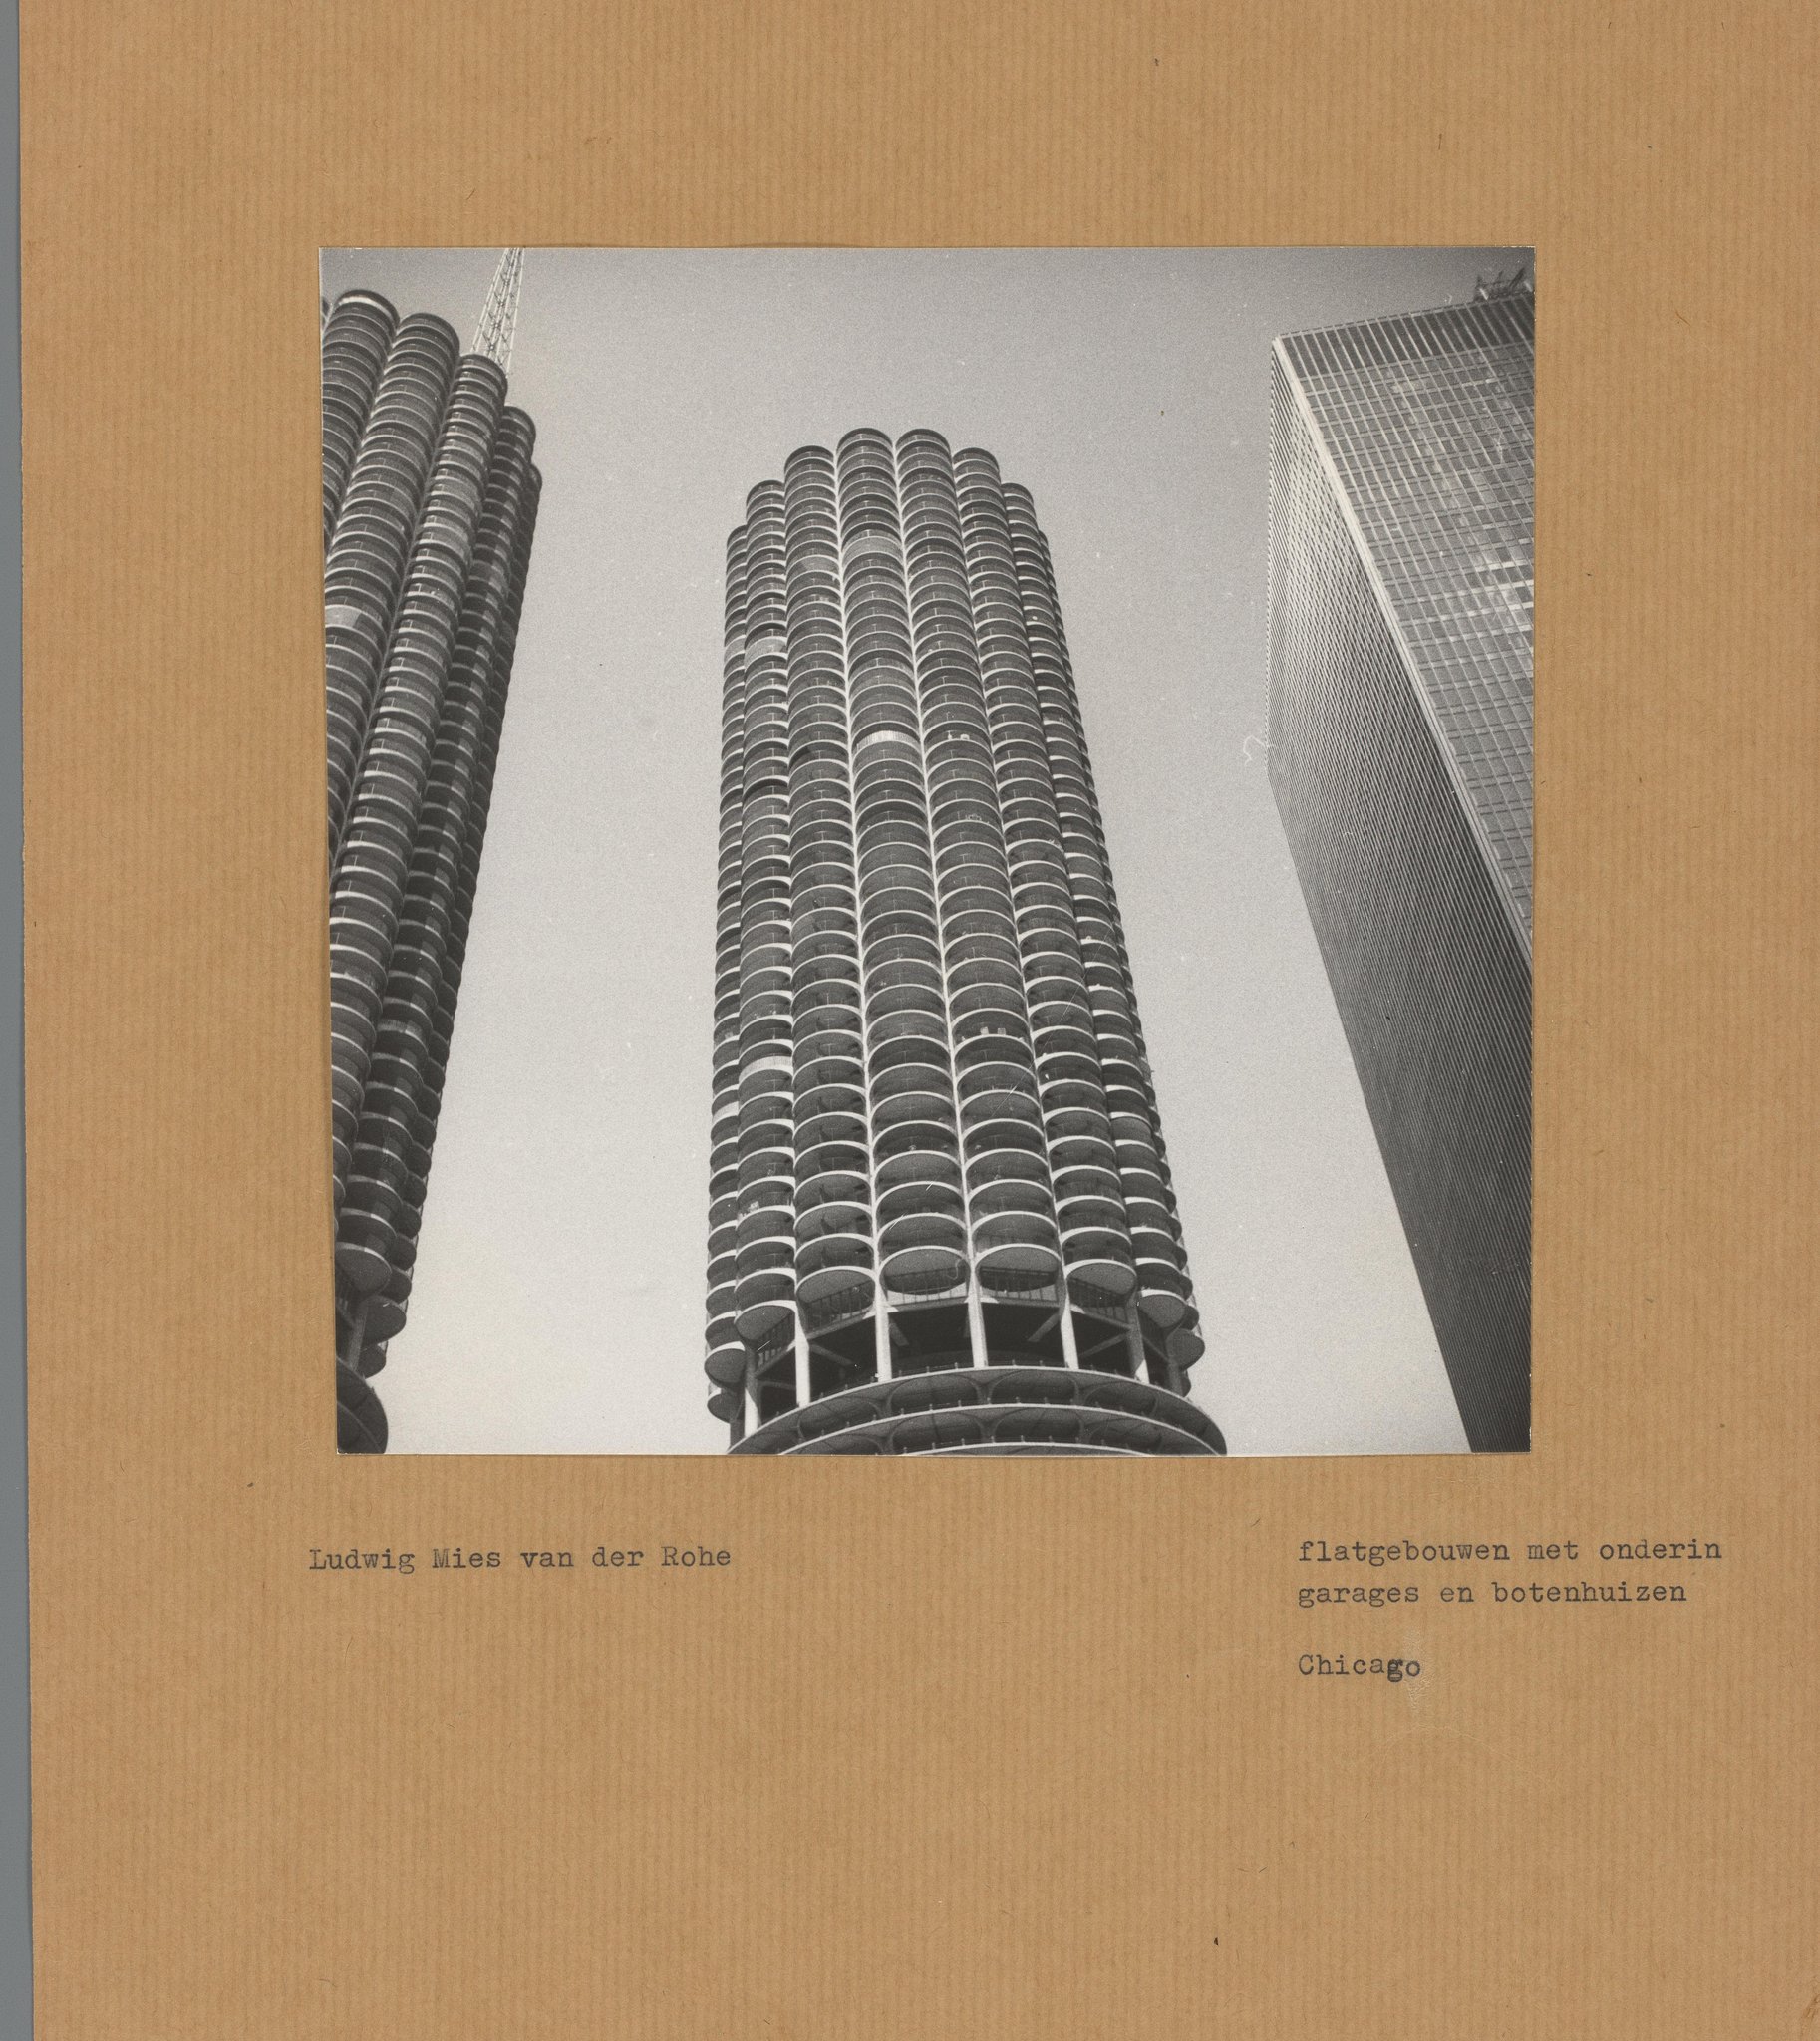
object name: photograph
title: Flatgebouw van Ludwig Mies van der Rohe, Chicago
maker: iohan quirijn van regteren altena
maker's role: painter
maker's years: 1899-1980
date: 1971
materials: photographic support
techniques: gelatin silver print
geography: chicago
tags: moskou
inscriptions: annotation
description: Een foto van flatgebouw, Chicago op drager.